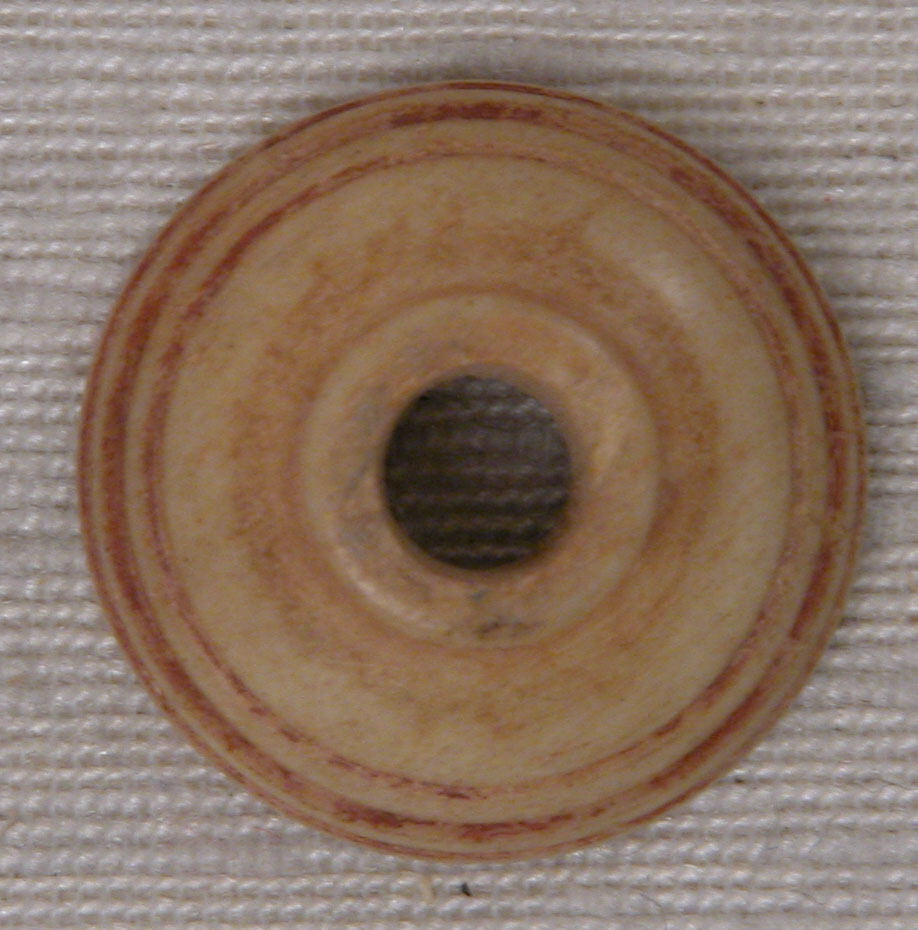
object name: button or bead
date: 801-1000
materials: bone, paint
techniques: incising, inlay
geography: iran